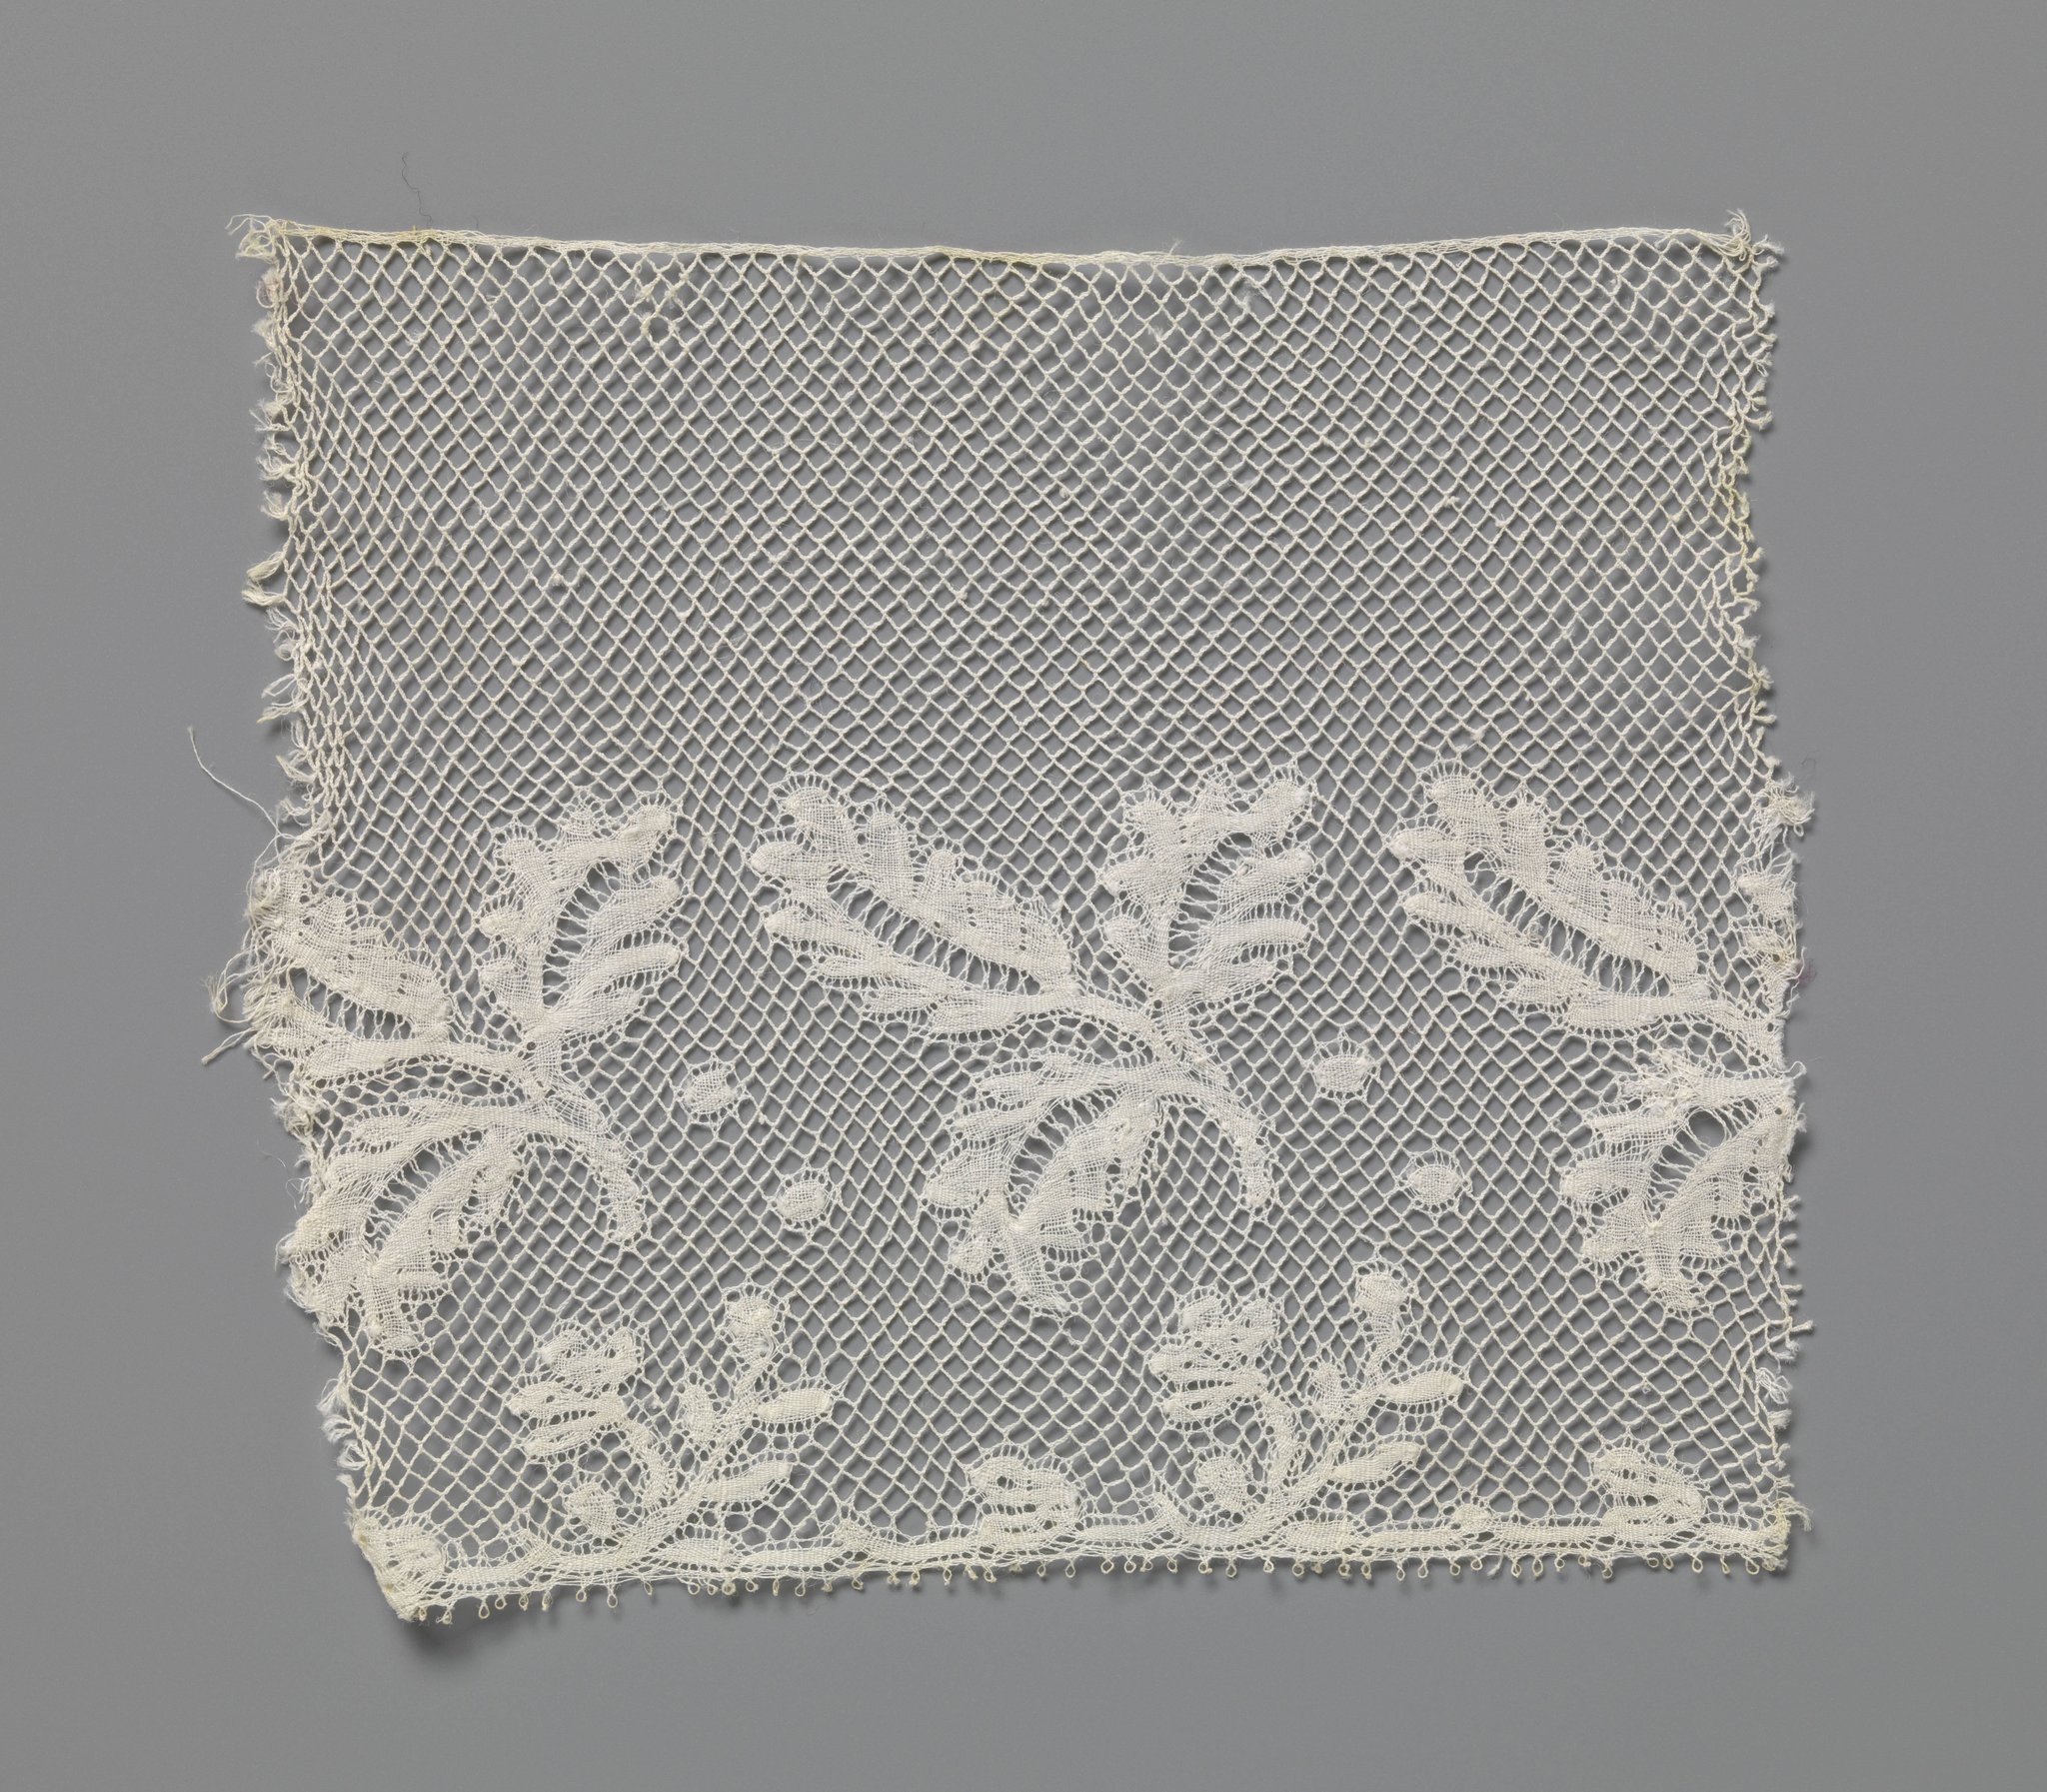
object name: strip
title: Strook kloskant met drieblad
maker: Anonymous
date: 1820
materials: linen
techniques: lace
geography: ieper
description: Op een fijn mazennet staat in de buitenste helft een stijve rij van drie-delige blaadjes, die eenzijdig gericht zijn. Een rechte rand vertoont kleinere, tegengesteld gerichte bloemtakjes. Valenciennes-kant.